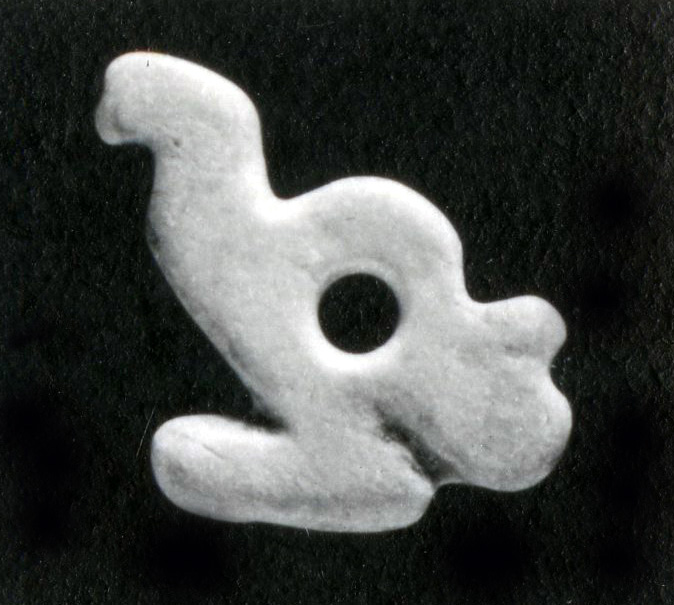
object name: amulet, duck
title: Duckling amulet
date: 2110-2030 BCE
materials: ivory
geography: egypt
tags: ducks